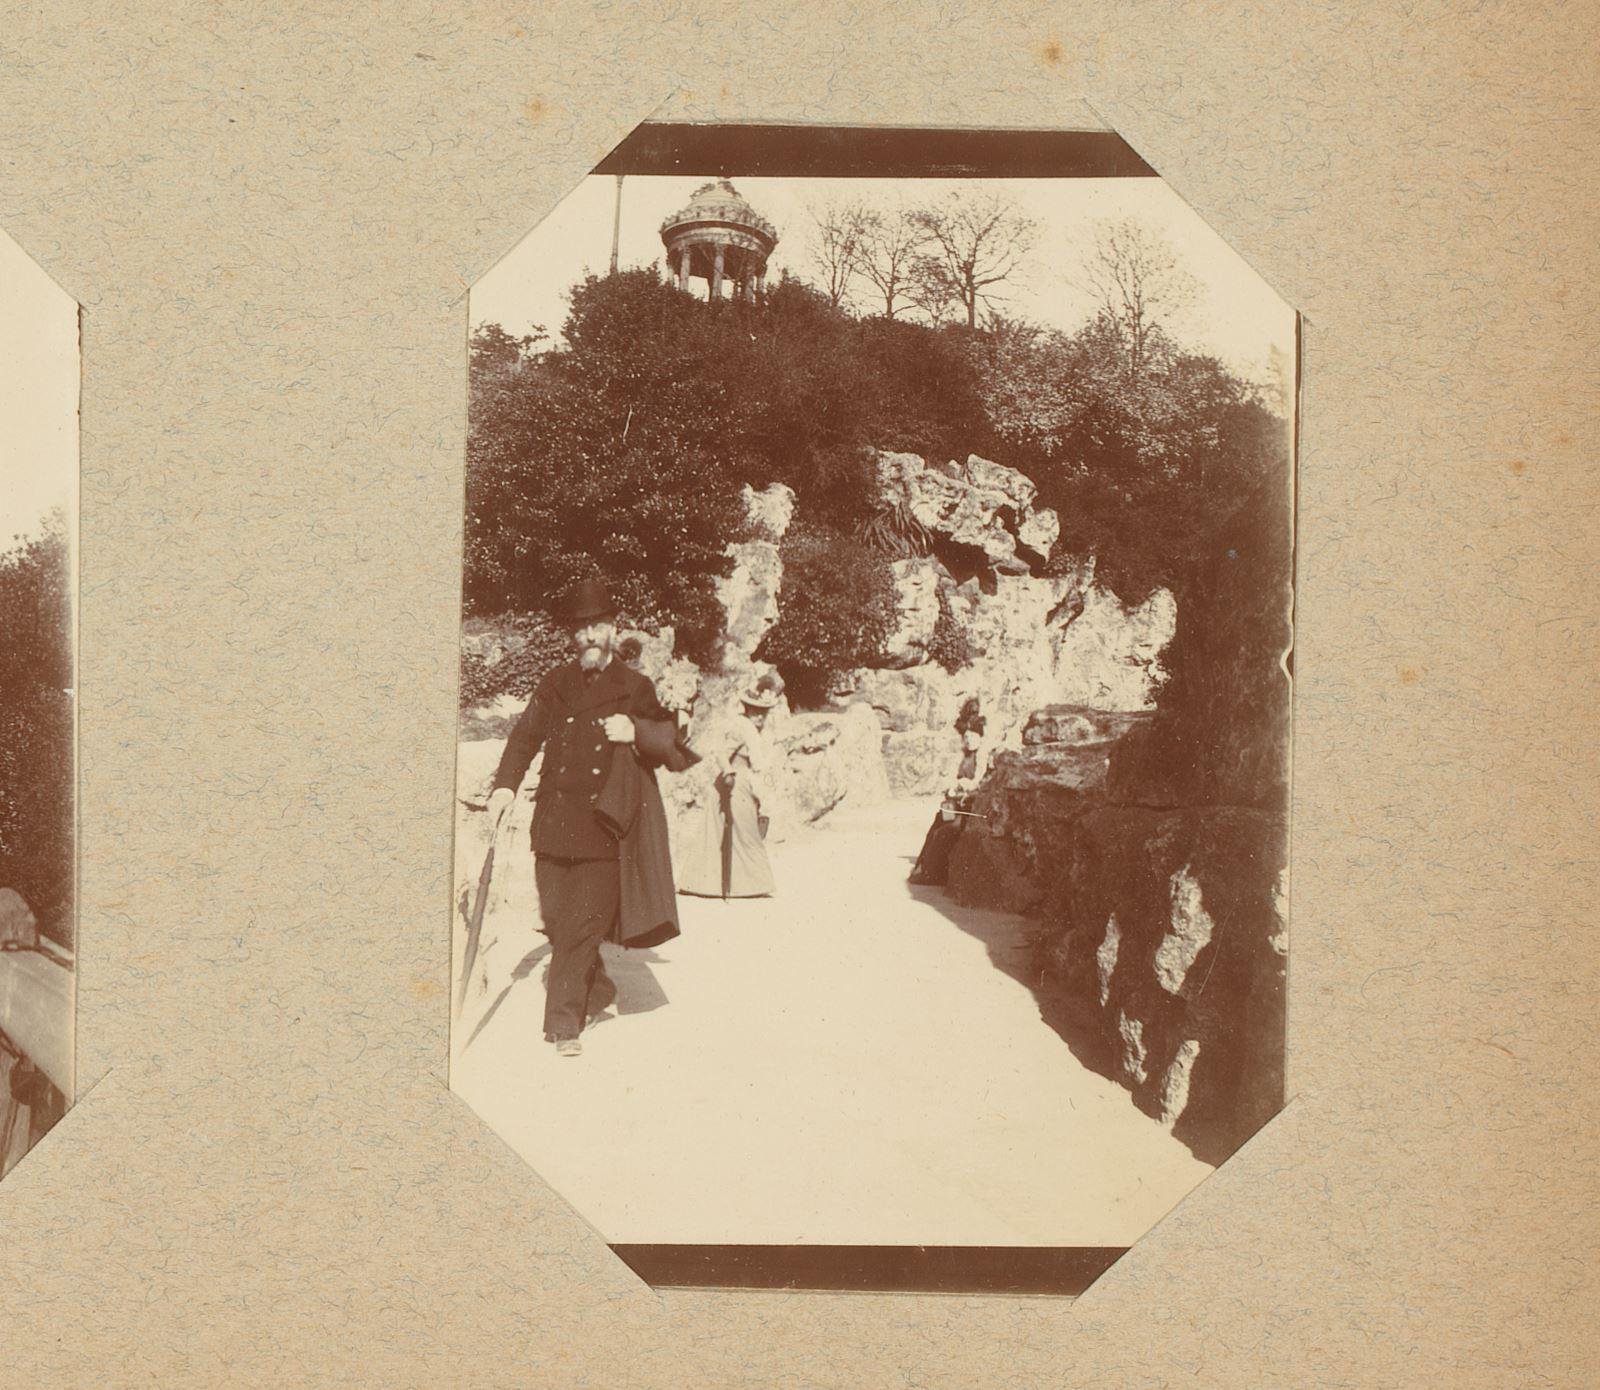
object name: photograph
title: Man en twee vrouwen in een park of tuin met paviljoen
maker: Anonymous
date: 1897-1900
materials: paper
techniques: gelatin silver print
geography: france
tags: strolling, public gardens, park, france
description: Over de foto is een ander negatief afgedrukt van een voorstelling van bomen.